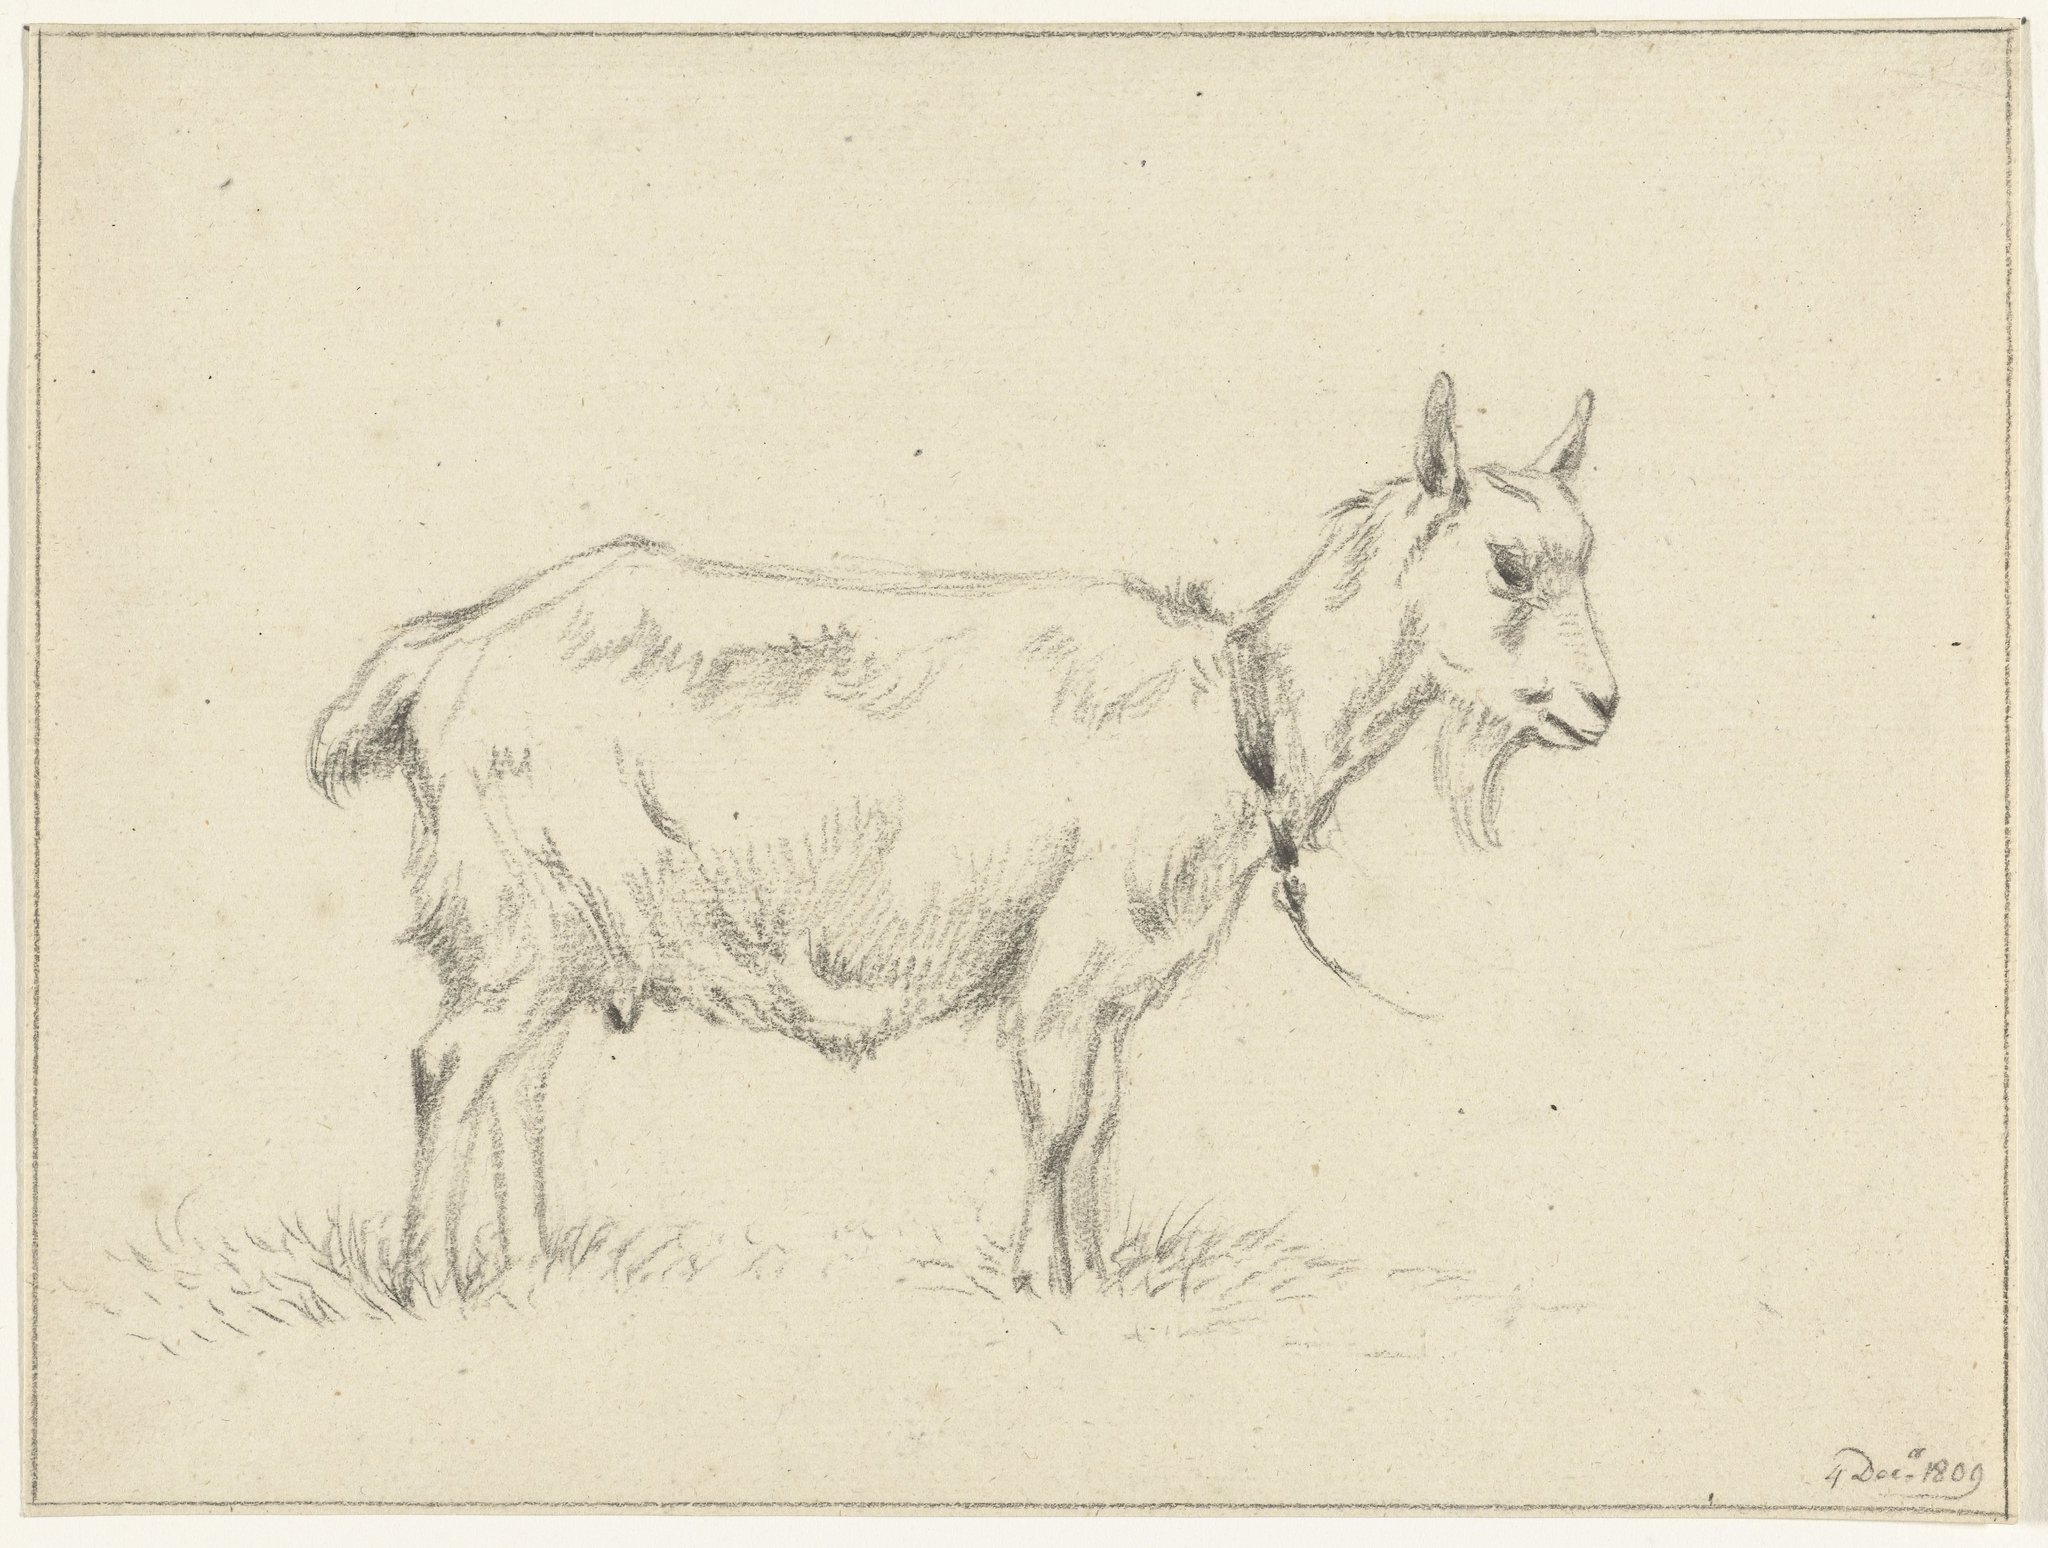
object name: drawing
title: Staande geit, naar rechts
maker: jean bernard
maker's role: draughtsman, print maker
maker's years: 1765-1833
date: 1809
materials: chalk, paper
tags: goat